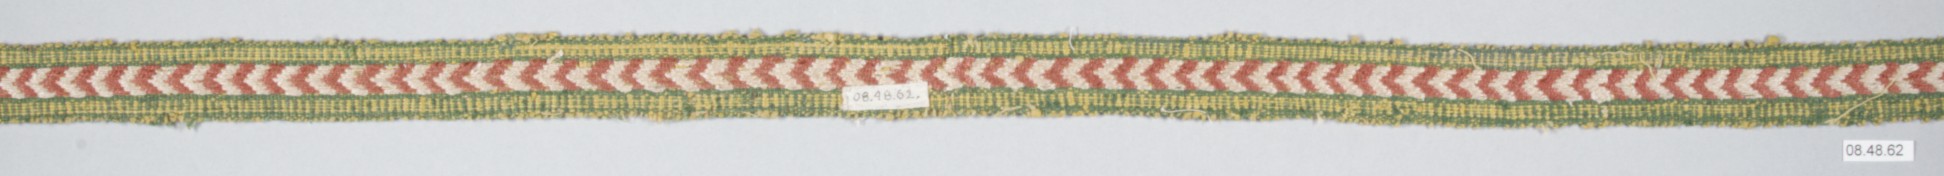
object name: galloon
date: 1801-1900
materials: silk